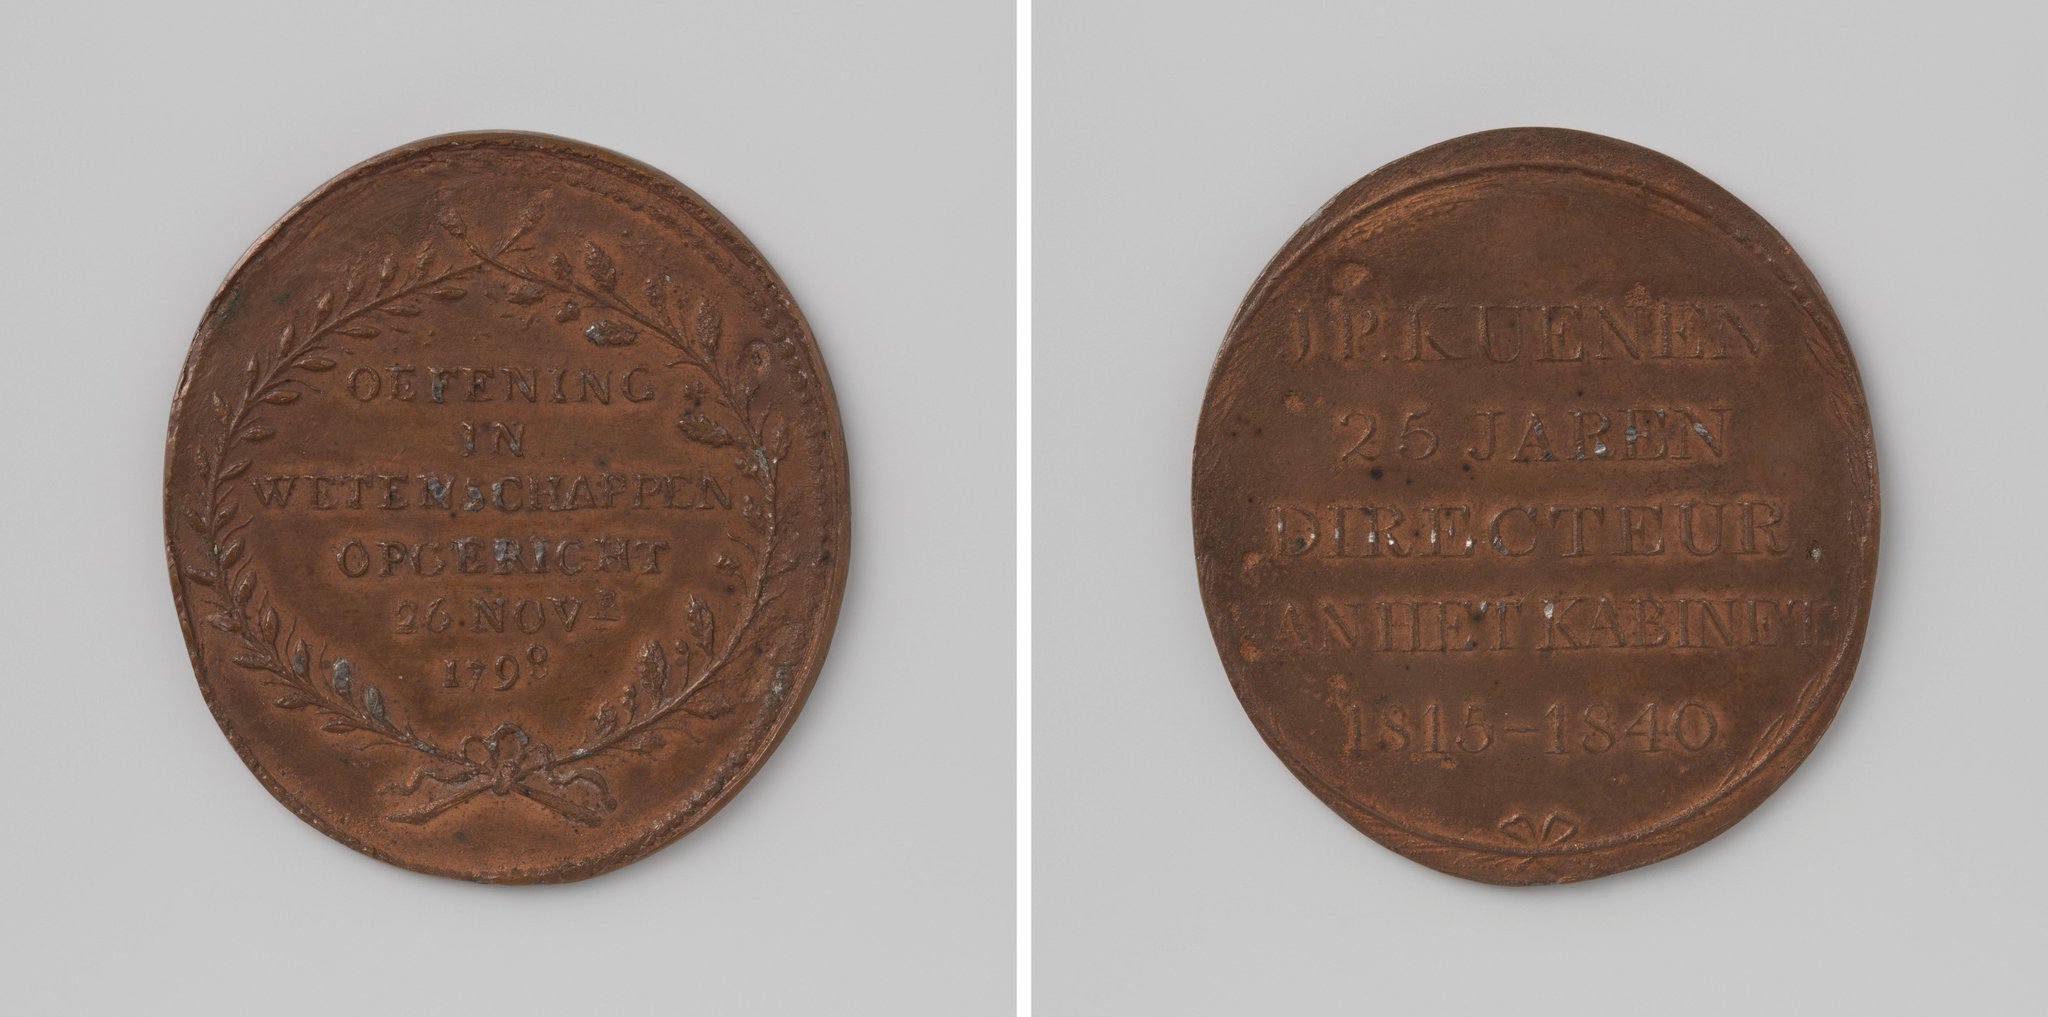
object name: honorary medal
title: Genootschap "Oefening in wetenschappen", ter ere van J.P. Kuenen, sedert vijfentwintig jaar directeur van het kabinet van het genootschap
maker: Anonymous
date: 1840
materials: bronze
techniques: striking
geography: netherlands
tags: haarlem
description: Bronzen ovale penning. Voorzijde: opschrift binnen tot krans samengebonden eike- en palmtak. Keerzijde: opschrift